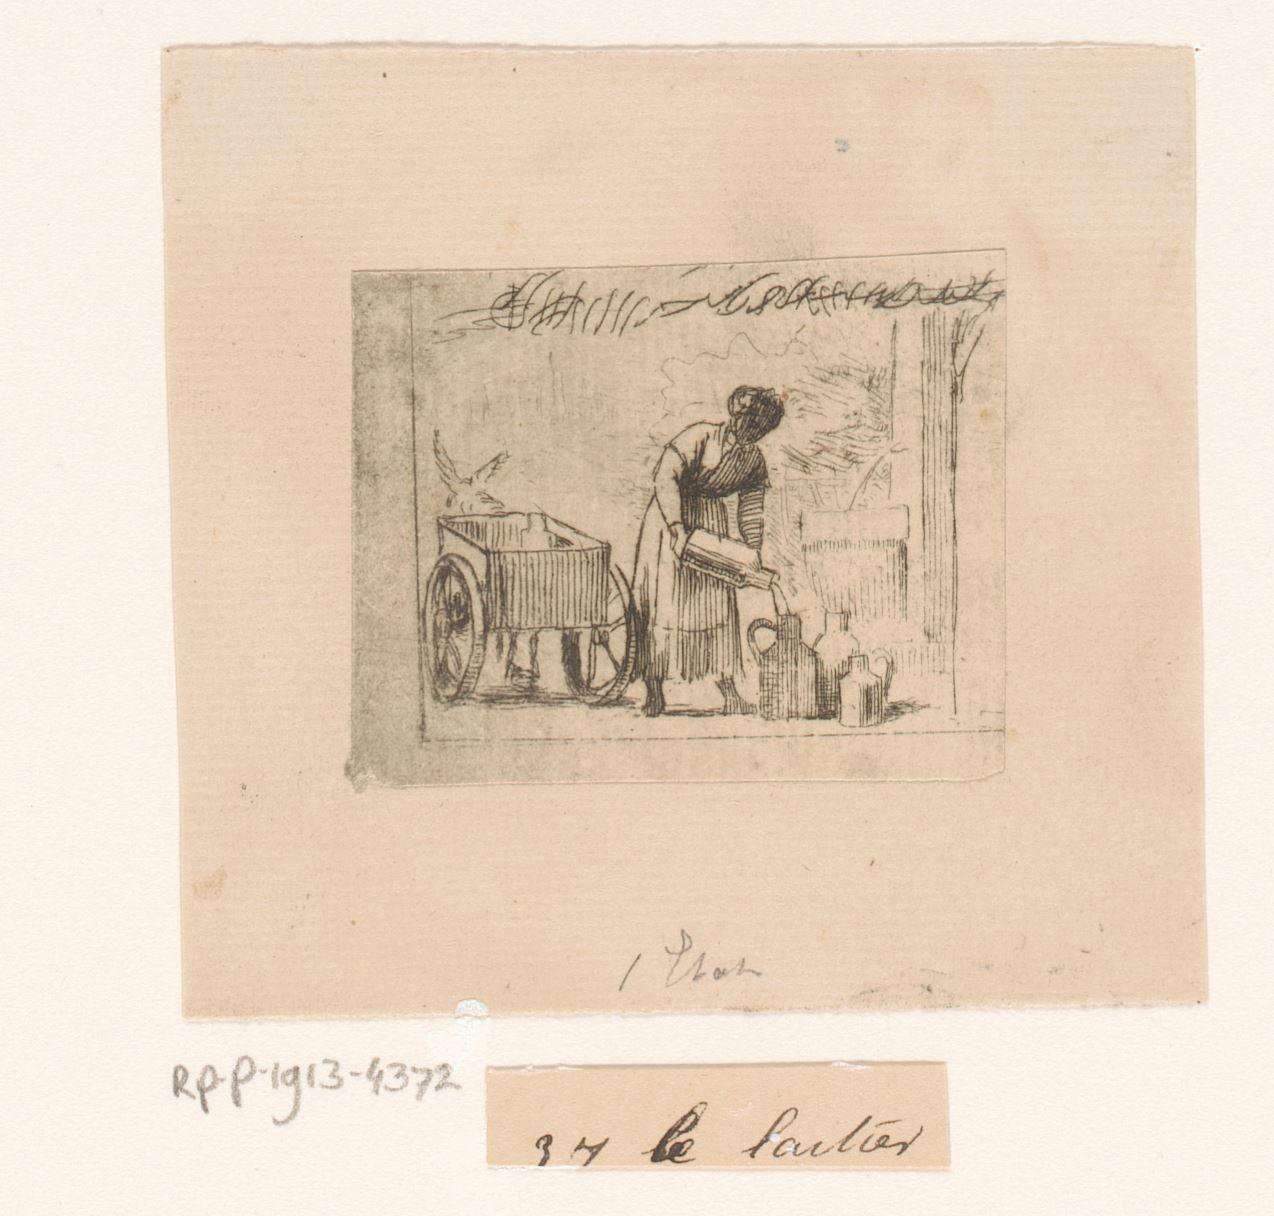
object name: print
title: Vrouw schenkt melk in een kruik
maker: adrien de witte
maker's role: print maker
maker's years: 1850-1935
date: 1860-1913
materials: paper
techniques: etching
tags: milkmaid, two-wheeled vehicle drawn by one animal, transportation of milk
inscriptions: collector's mark: Lugt 2228